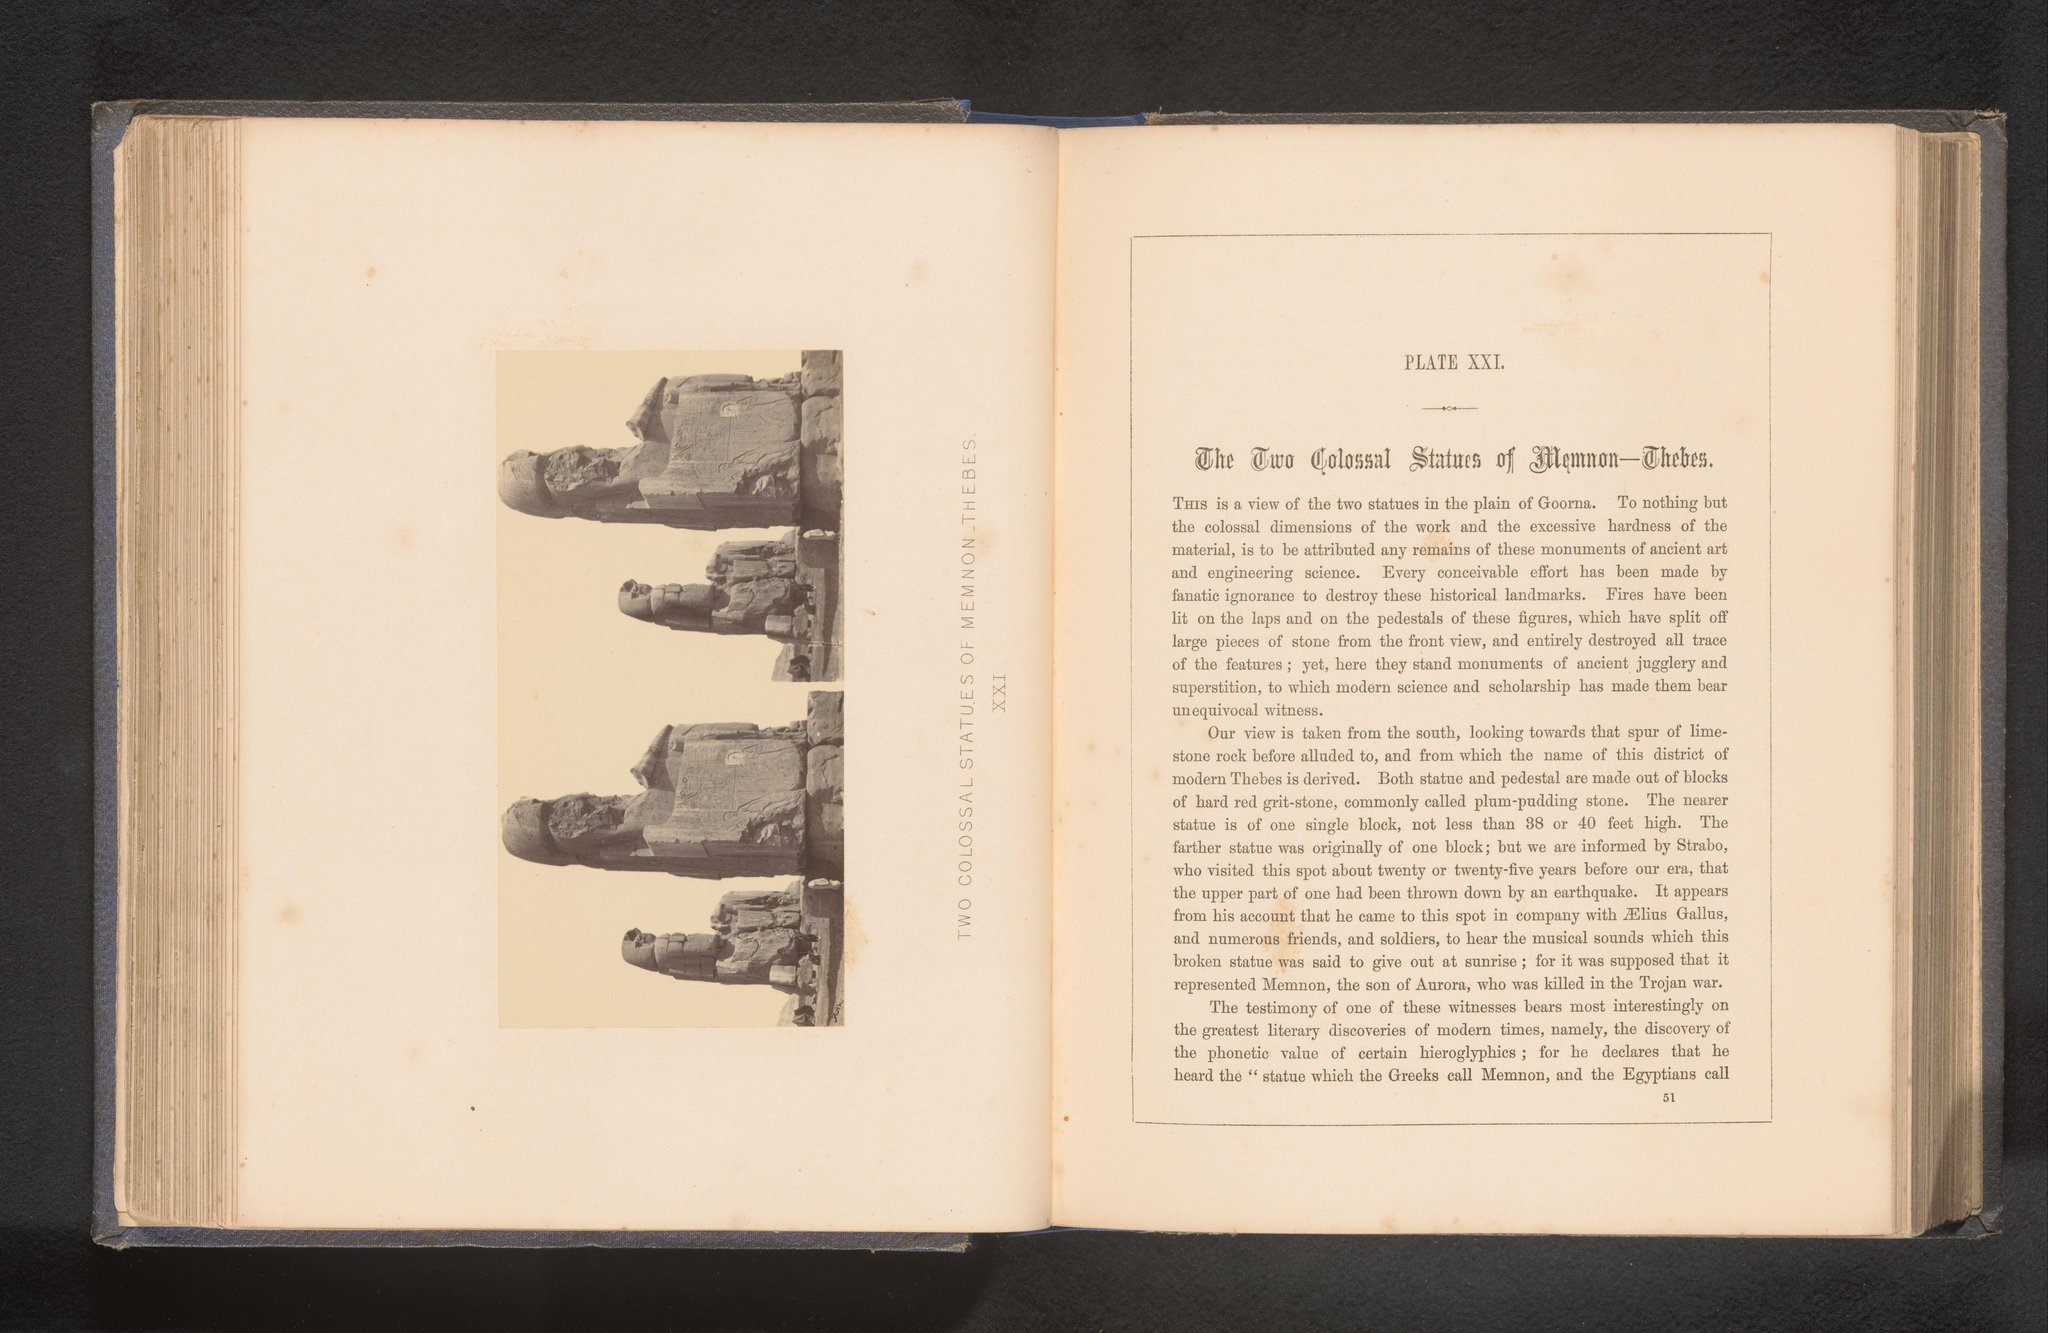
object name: stereograph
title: Kolossen van Memnon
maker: francis frith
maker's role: publisher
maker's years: 1822-1898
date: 1857-1862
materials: photographic support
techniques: albumen print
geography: thebes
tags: monument, statue, king, thebes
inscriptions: number: ‘XXI’, name: ‘Frith’